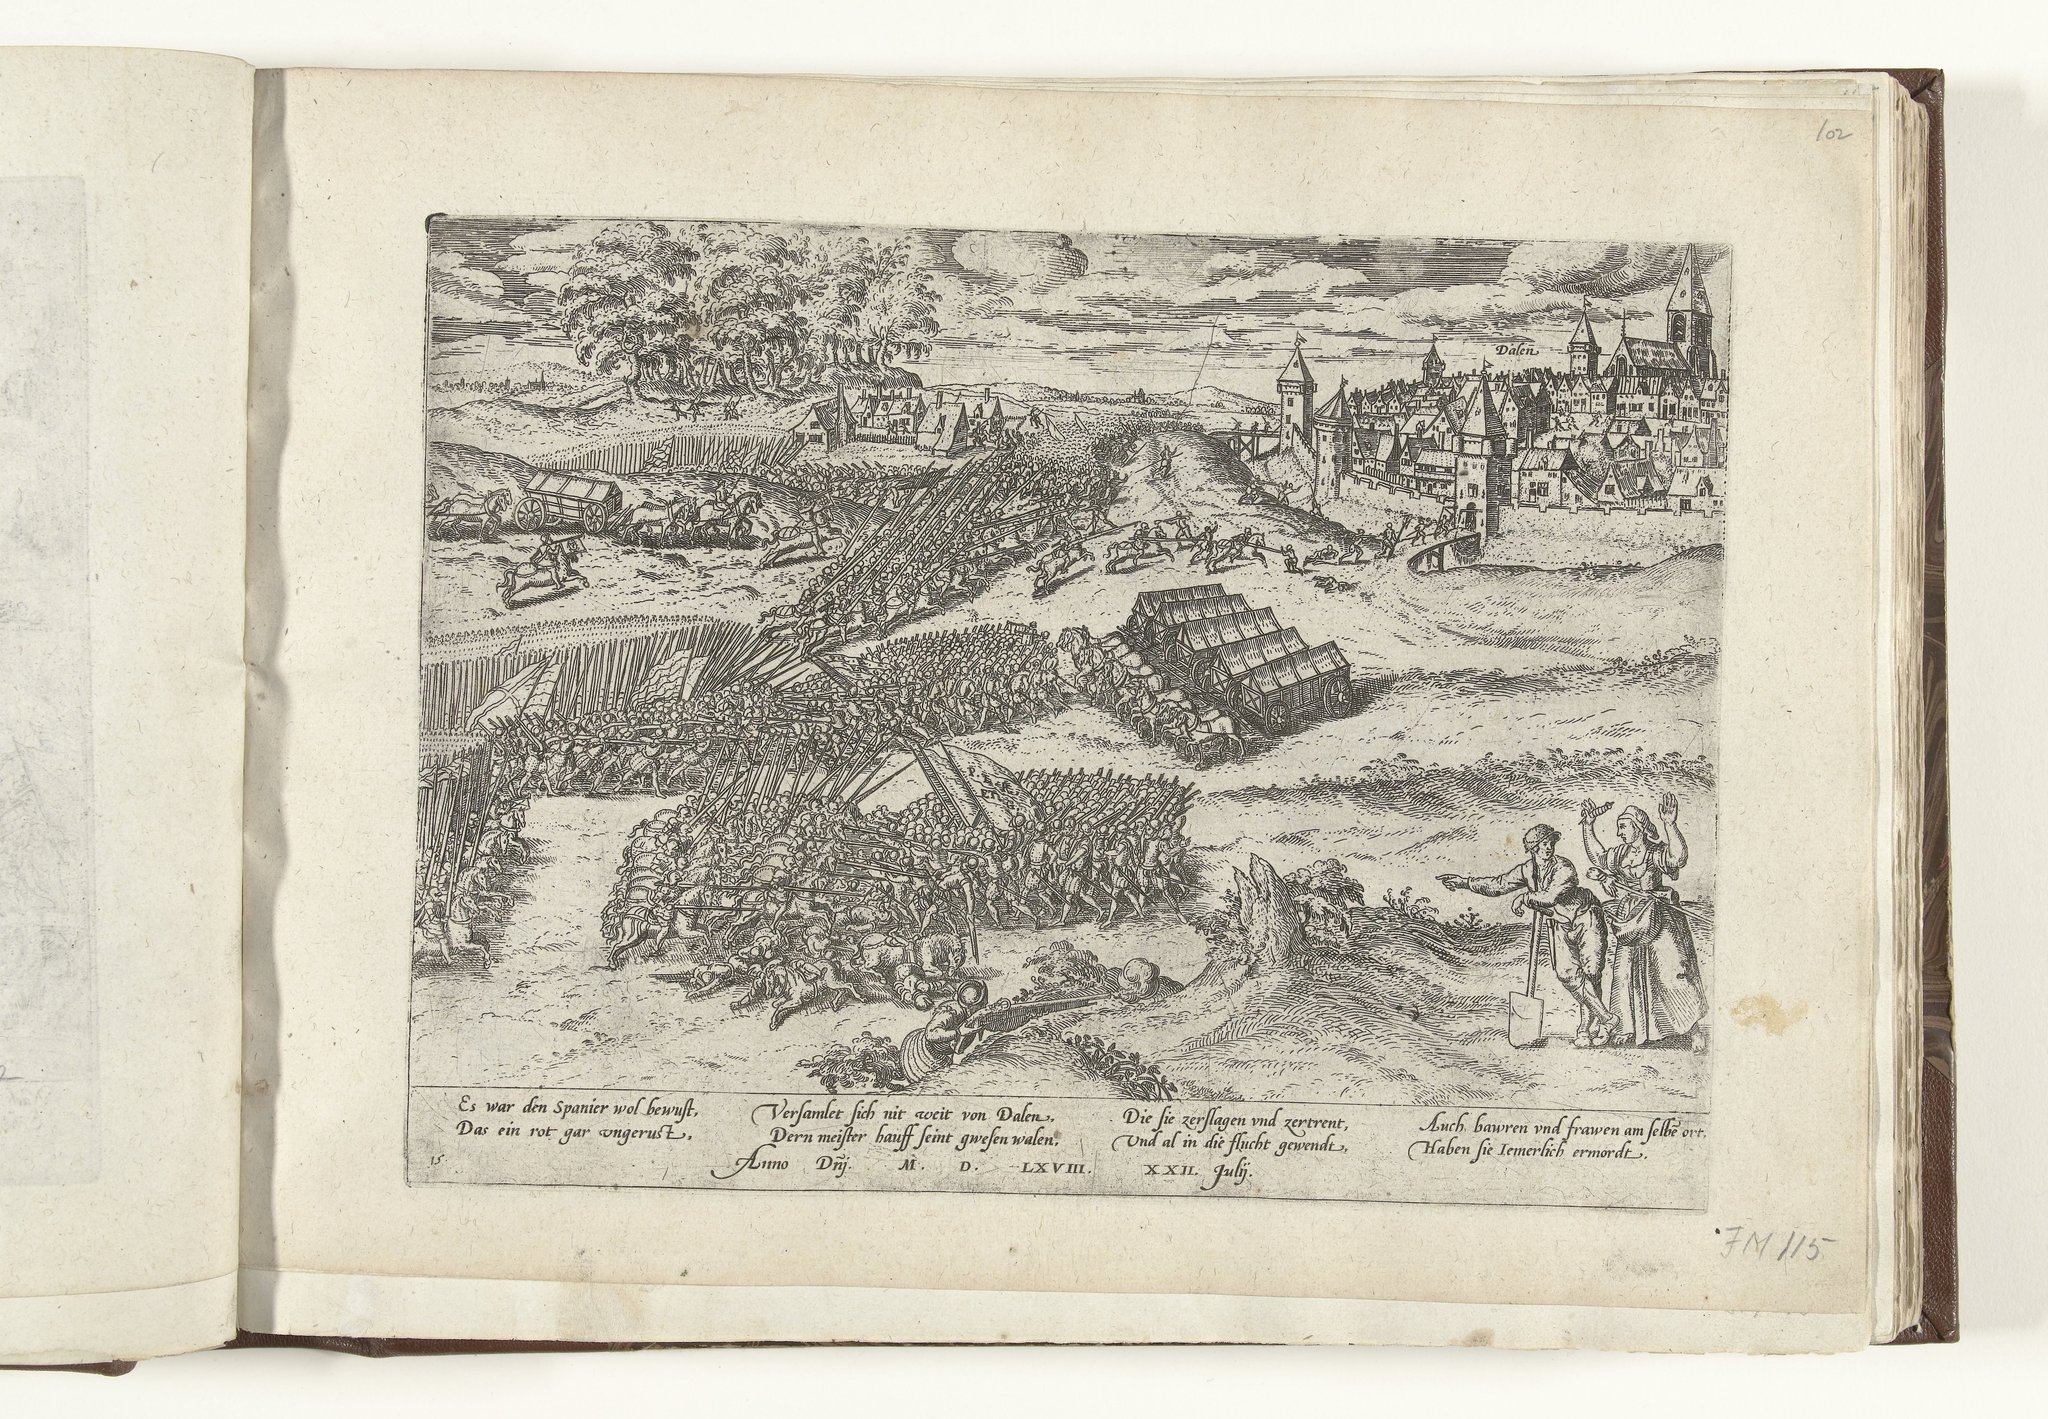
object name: album leaf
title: Serie 5: Nederlandse Gebeurtenissen, 1566-1570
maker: frans hogenberg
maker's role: print maker, publisher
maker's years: 1538-1590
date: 1568-1570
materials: paper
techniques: etching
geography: cologne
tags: battle (+ land forces)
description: Slag bij Dahlen of Daalheim. Op de prent vermeld als 22 juli 1568, in werkelijkheid op 25 april. Op de voorgrond twee landlieden die kijken naar de veldslag, in de verte de stad Dahlen. Met onderschrift van 8 regels in het Duits. Genummerd: 15.